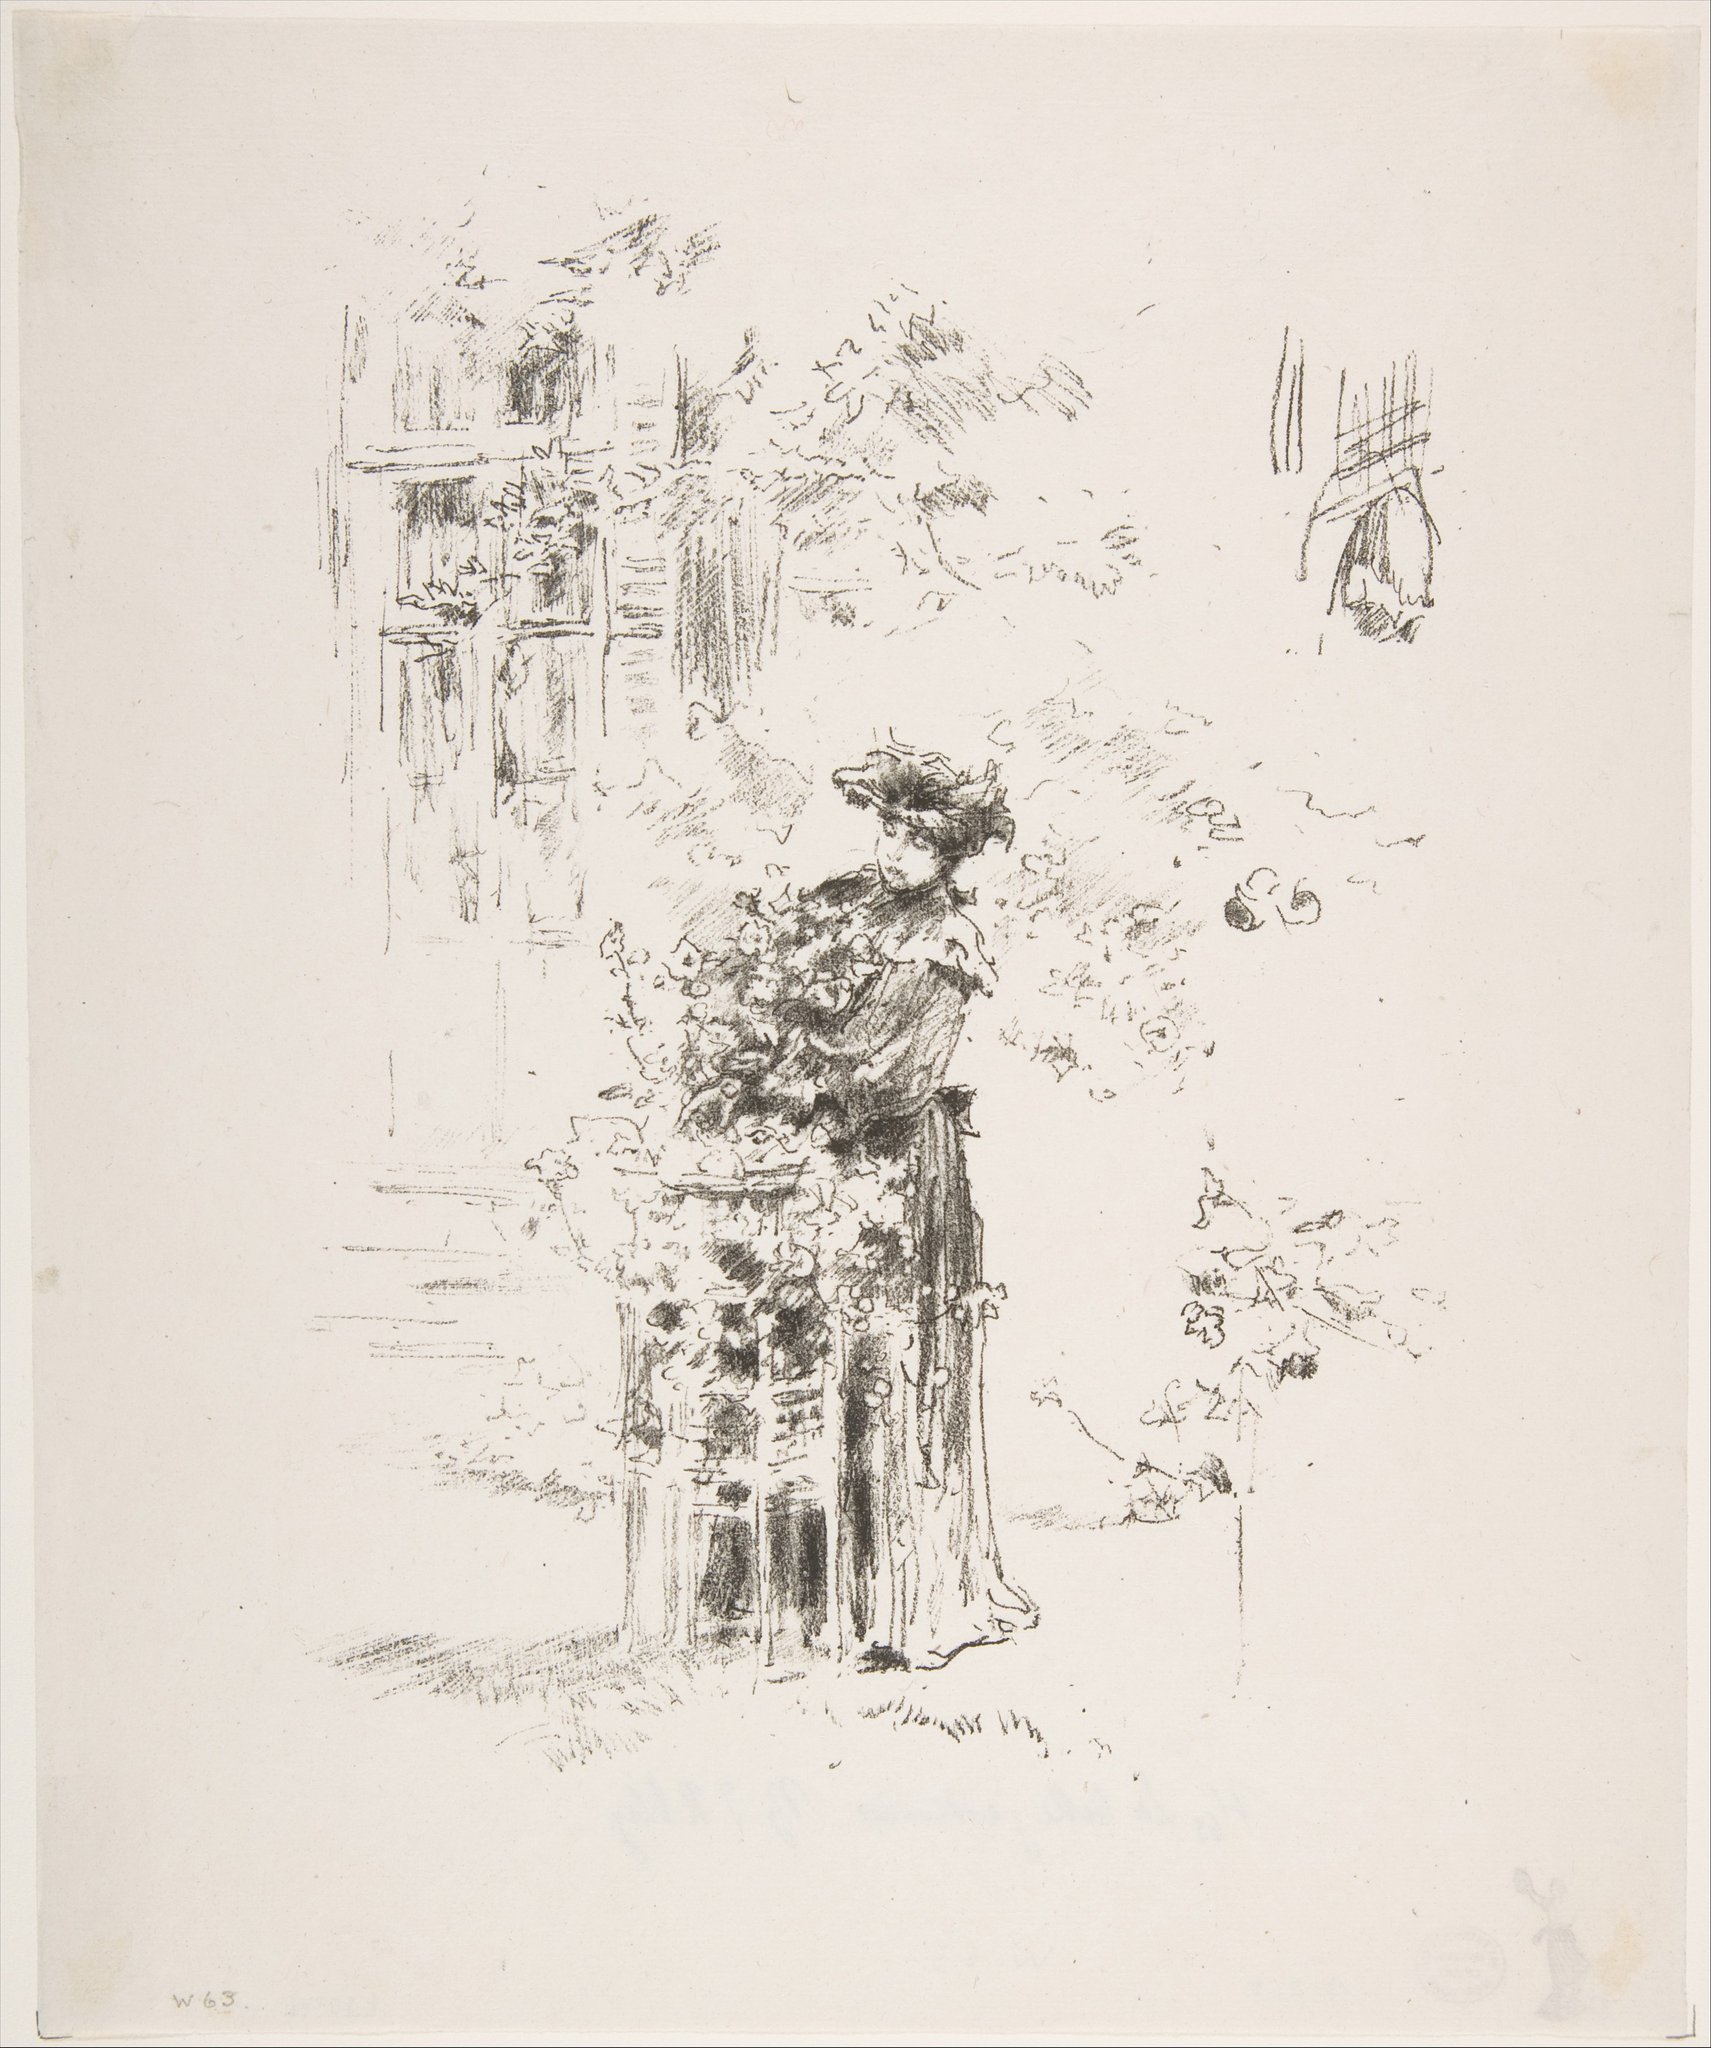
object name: print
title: La Belle Jardinière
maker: james mcneill whistler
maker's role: artist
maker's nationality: american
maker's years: 1834-1903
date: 1894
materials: ink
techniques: printing, scraping, stumping, lithography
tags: women,flowers